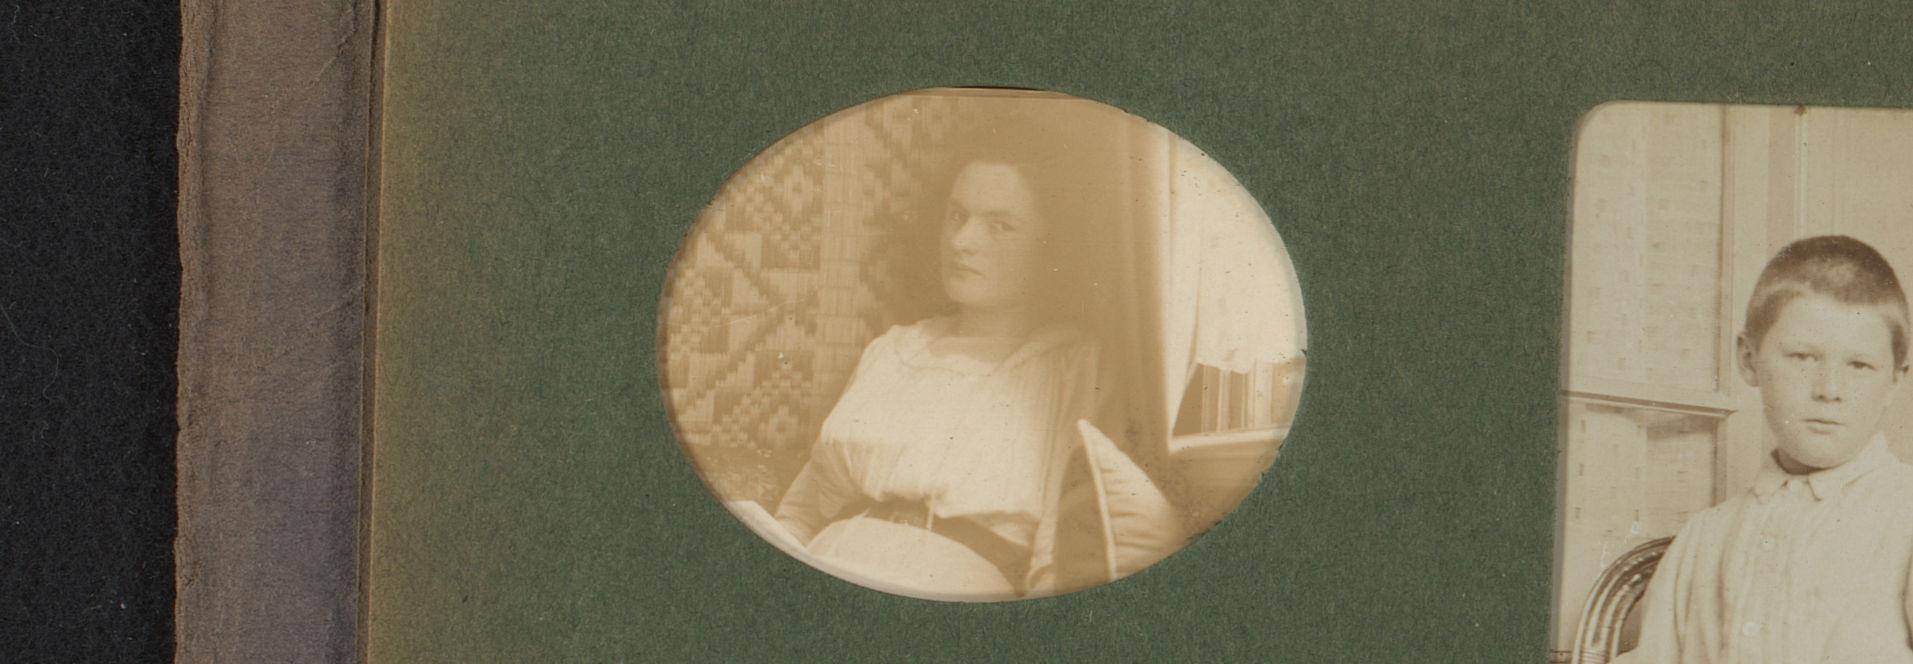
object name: album leaf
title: Portret van een jonge vrouw bij een raam, aangeduid als Wiesje Merkus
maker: Anonymous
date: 1910-1912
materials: paper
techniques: gelatin silver print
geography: gelderland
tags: wiesje merkus, adolescent, young woman, maiden, historical persons, gelderland